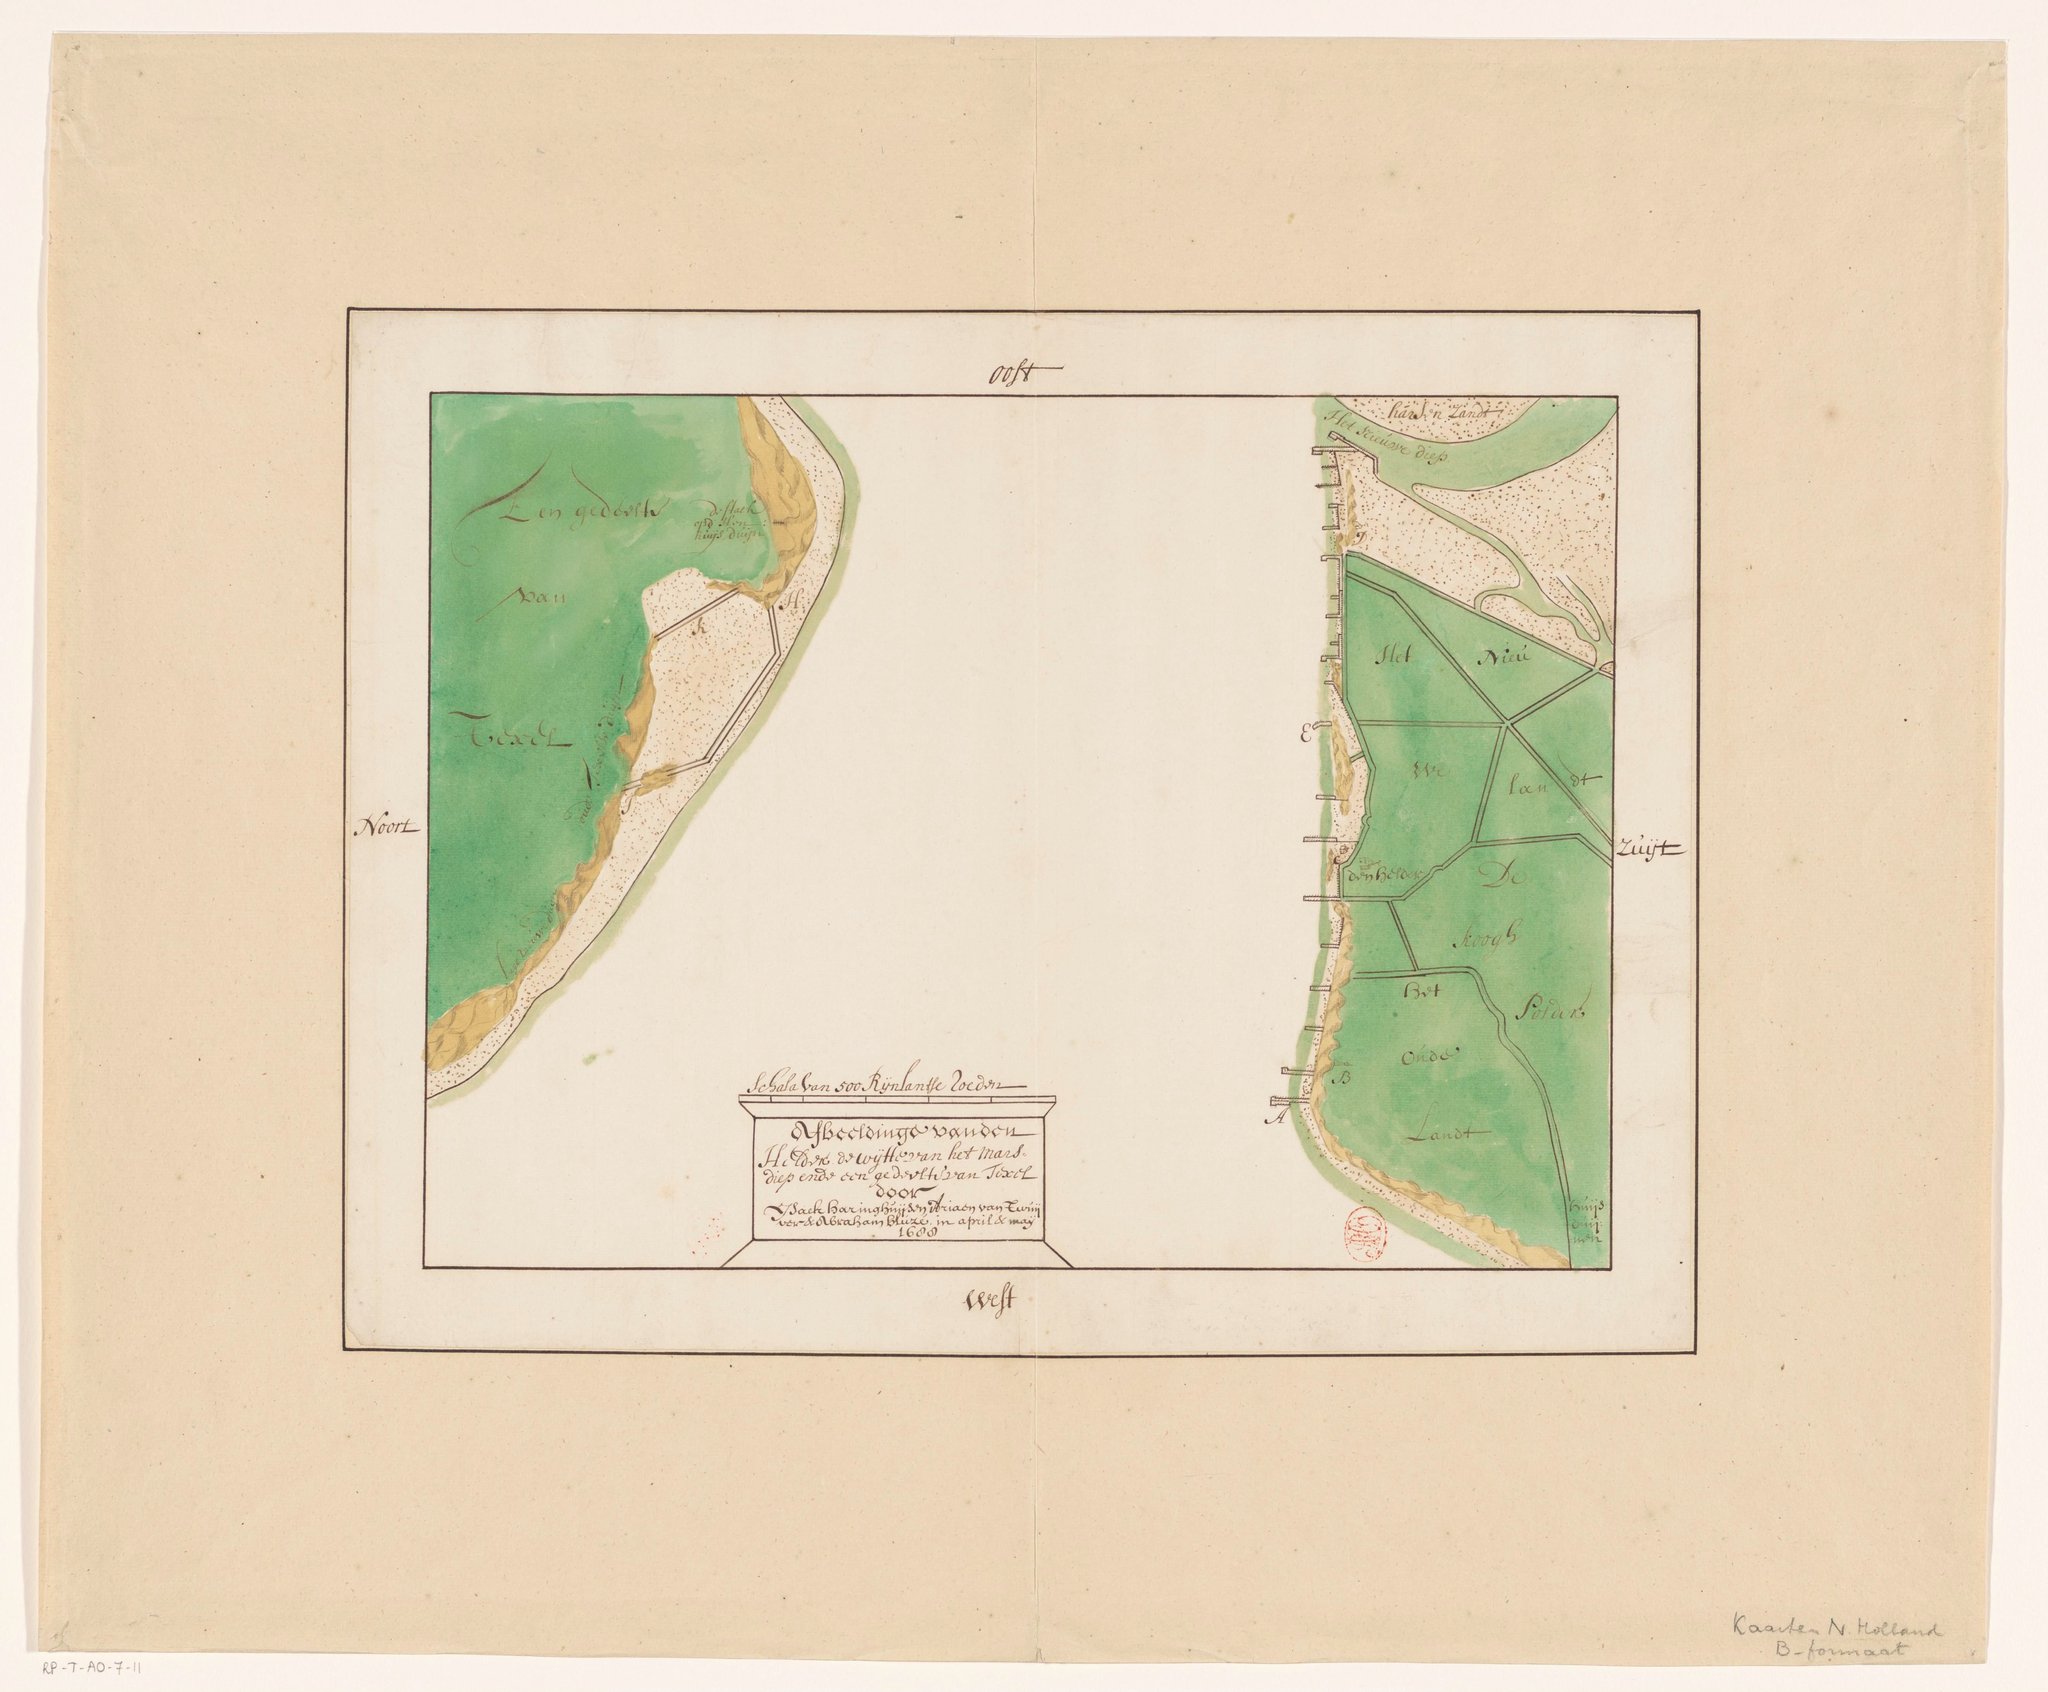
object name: drawing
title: Kaart van Den Helder en een deel van Texel met het tussenliggende Marsdiep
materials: ink, paper, watercolor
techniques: brush, pen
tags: maps of separate countries or regions, den helder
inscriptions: collector's mark: Lugt 195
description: Onderaan de titel met daarboven een schaalstok: Scala van 500 Rijnlantse roeden. Oriëntatie: het noorden links.